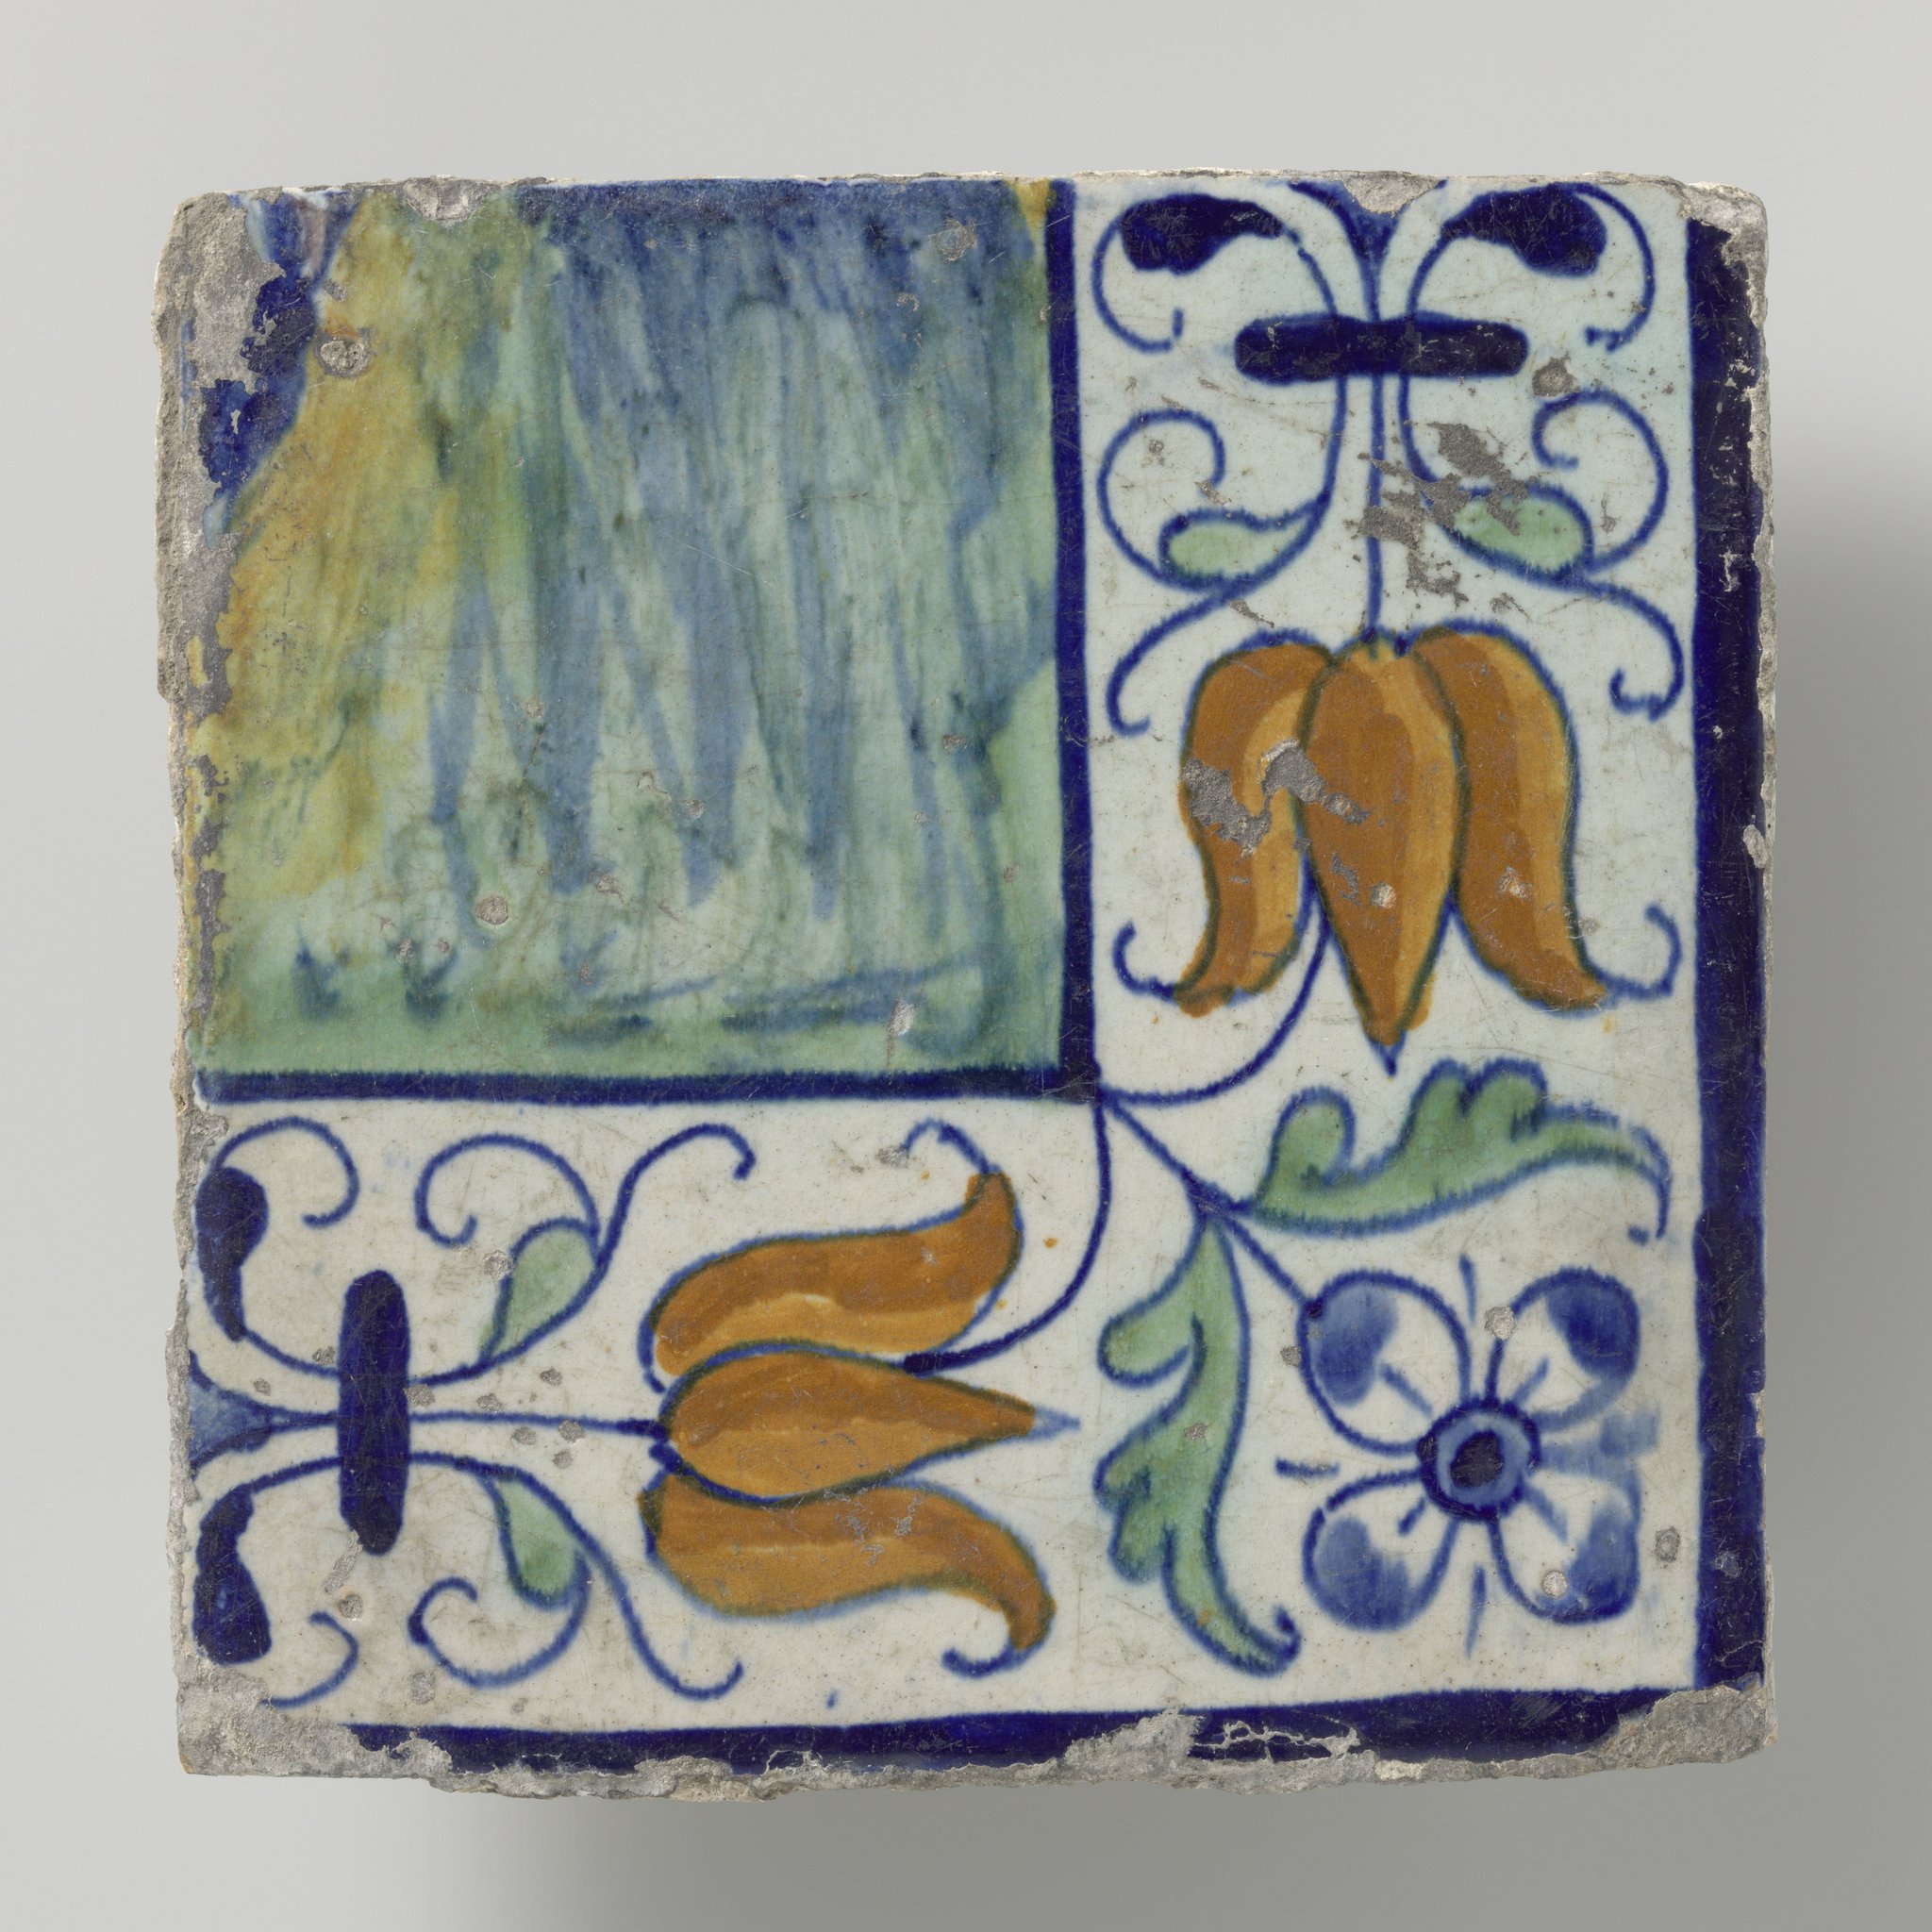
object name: tile tableau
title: Tegeltableau met prins Maurits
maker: Anonymous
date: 1600-1625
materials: earthenware, glaze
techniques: maiolica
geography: netherlands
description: Losse tegel behorende tot het tegeltableau met Prins Maurits.